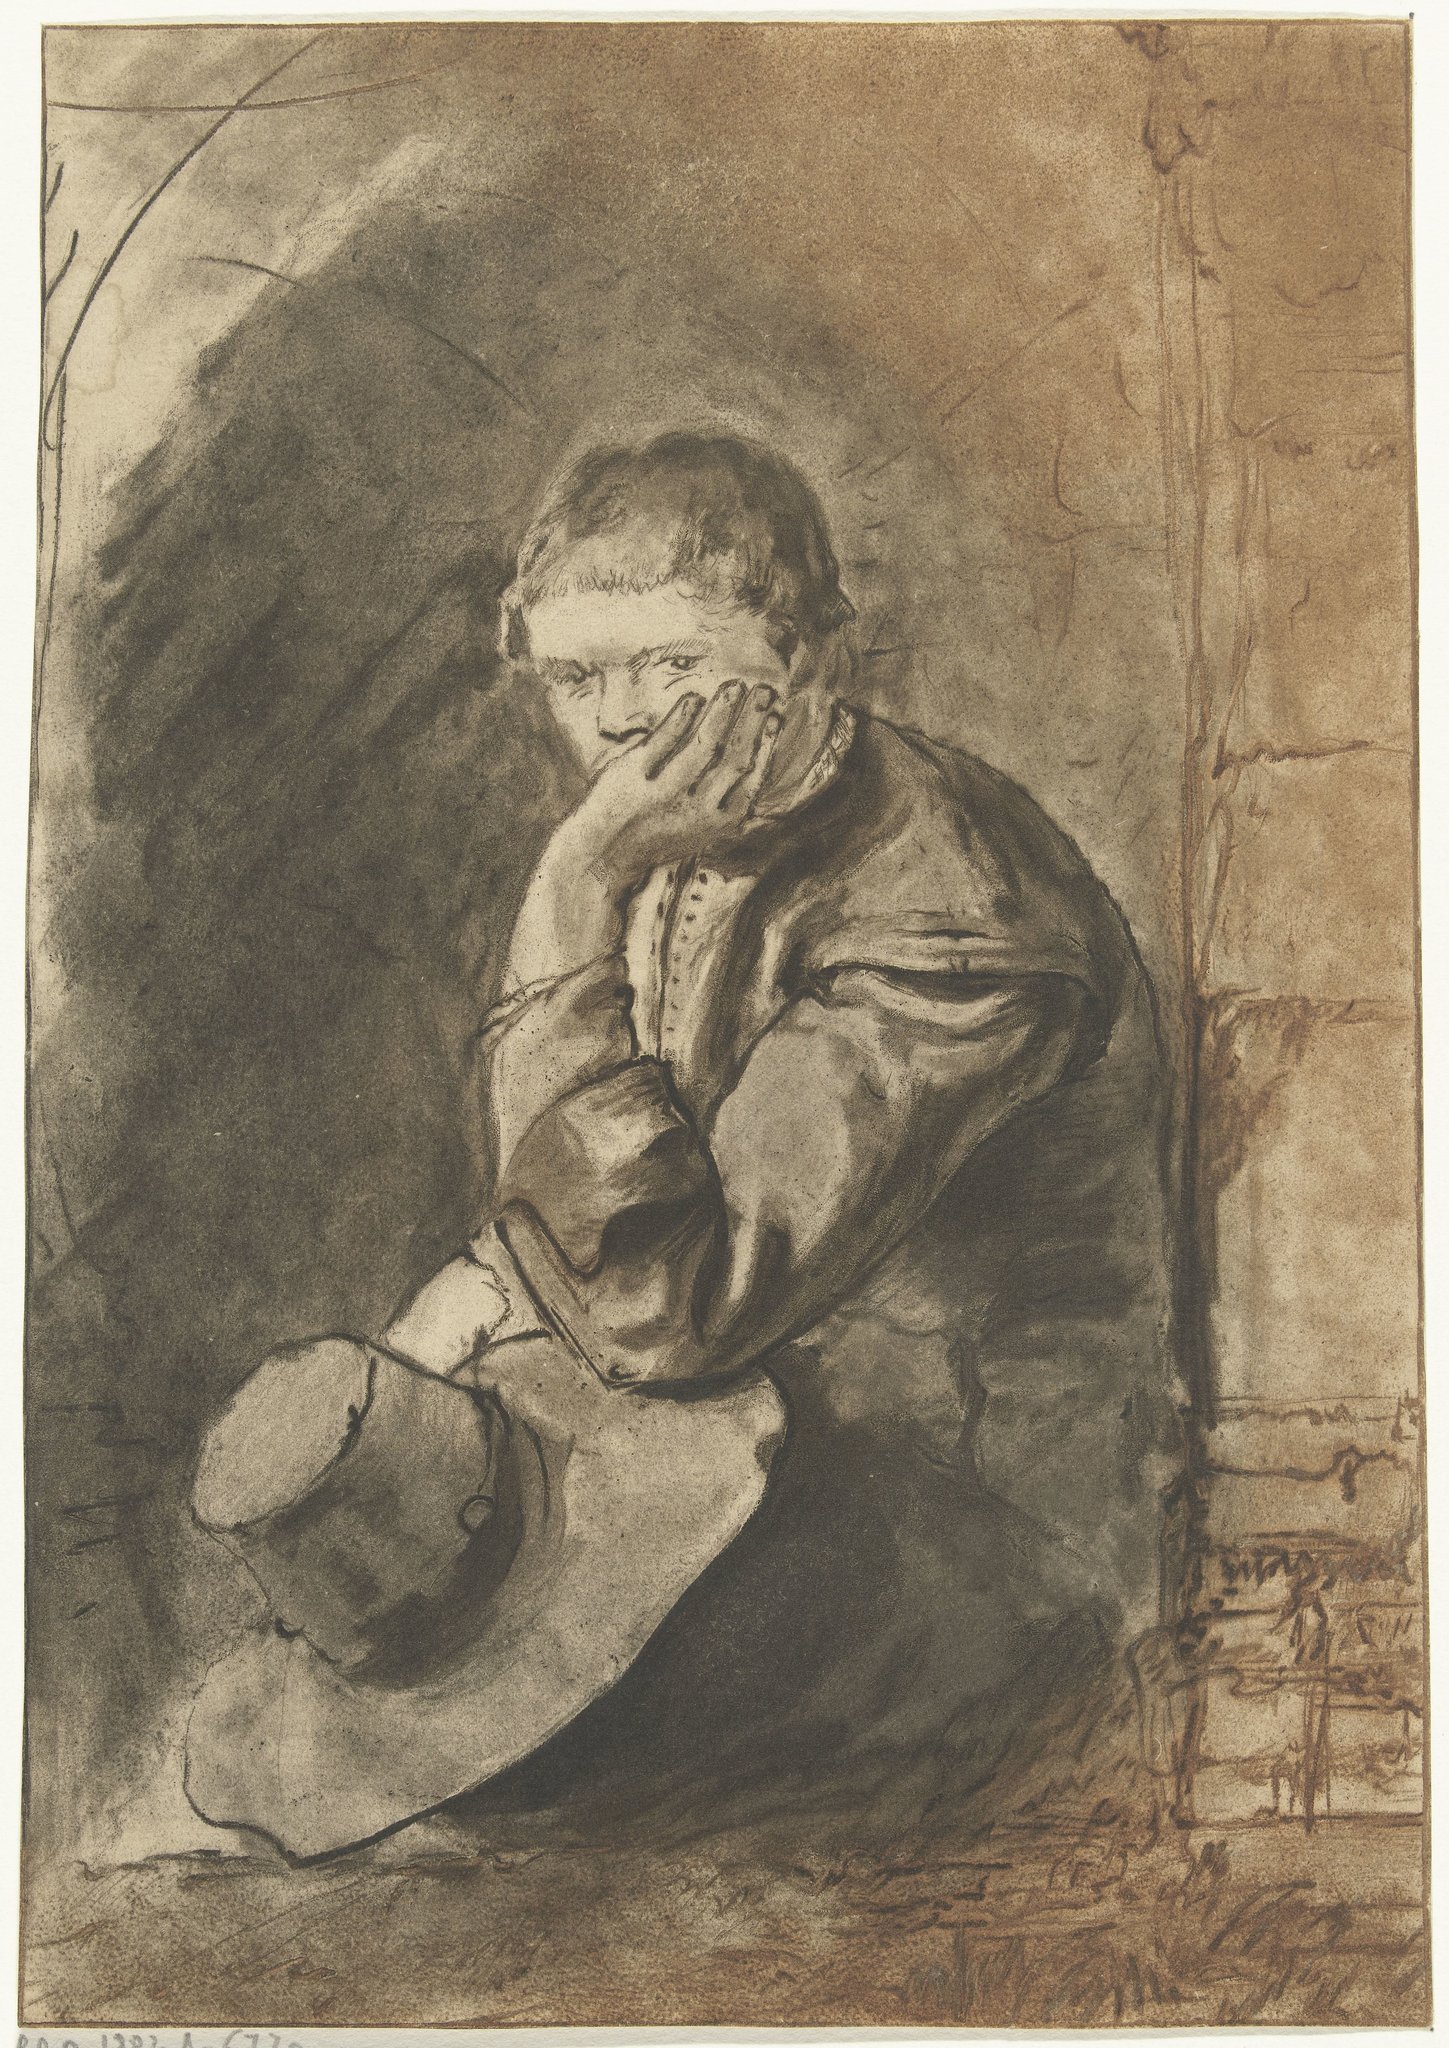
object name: print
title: Zittende man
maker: jurriaan cootwijck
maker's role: print maker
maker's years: 1714-1798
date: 1724-1798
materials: paper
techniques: aquatint, hand coloring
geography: amsterdam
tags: sitting figure (+ adult male (human being))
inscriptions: collector's mark: Lugt 2228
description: Een man zit in een nis. Met zijn ene hand ondersteunt hij zijn hoofd. In zijn andere hand houdt hij zijn hoed vast.